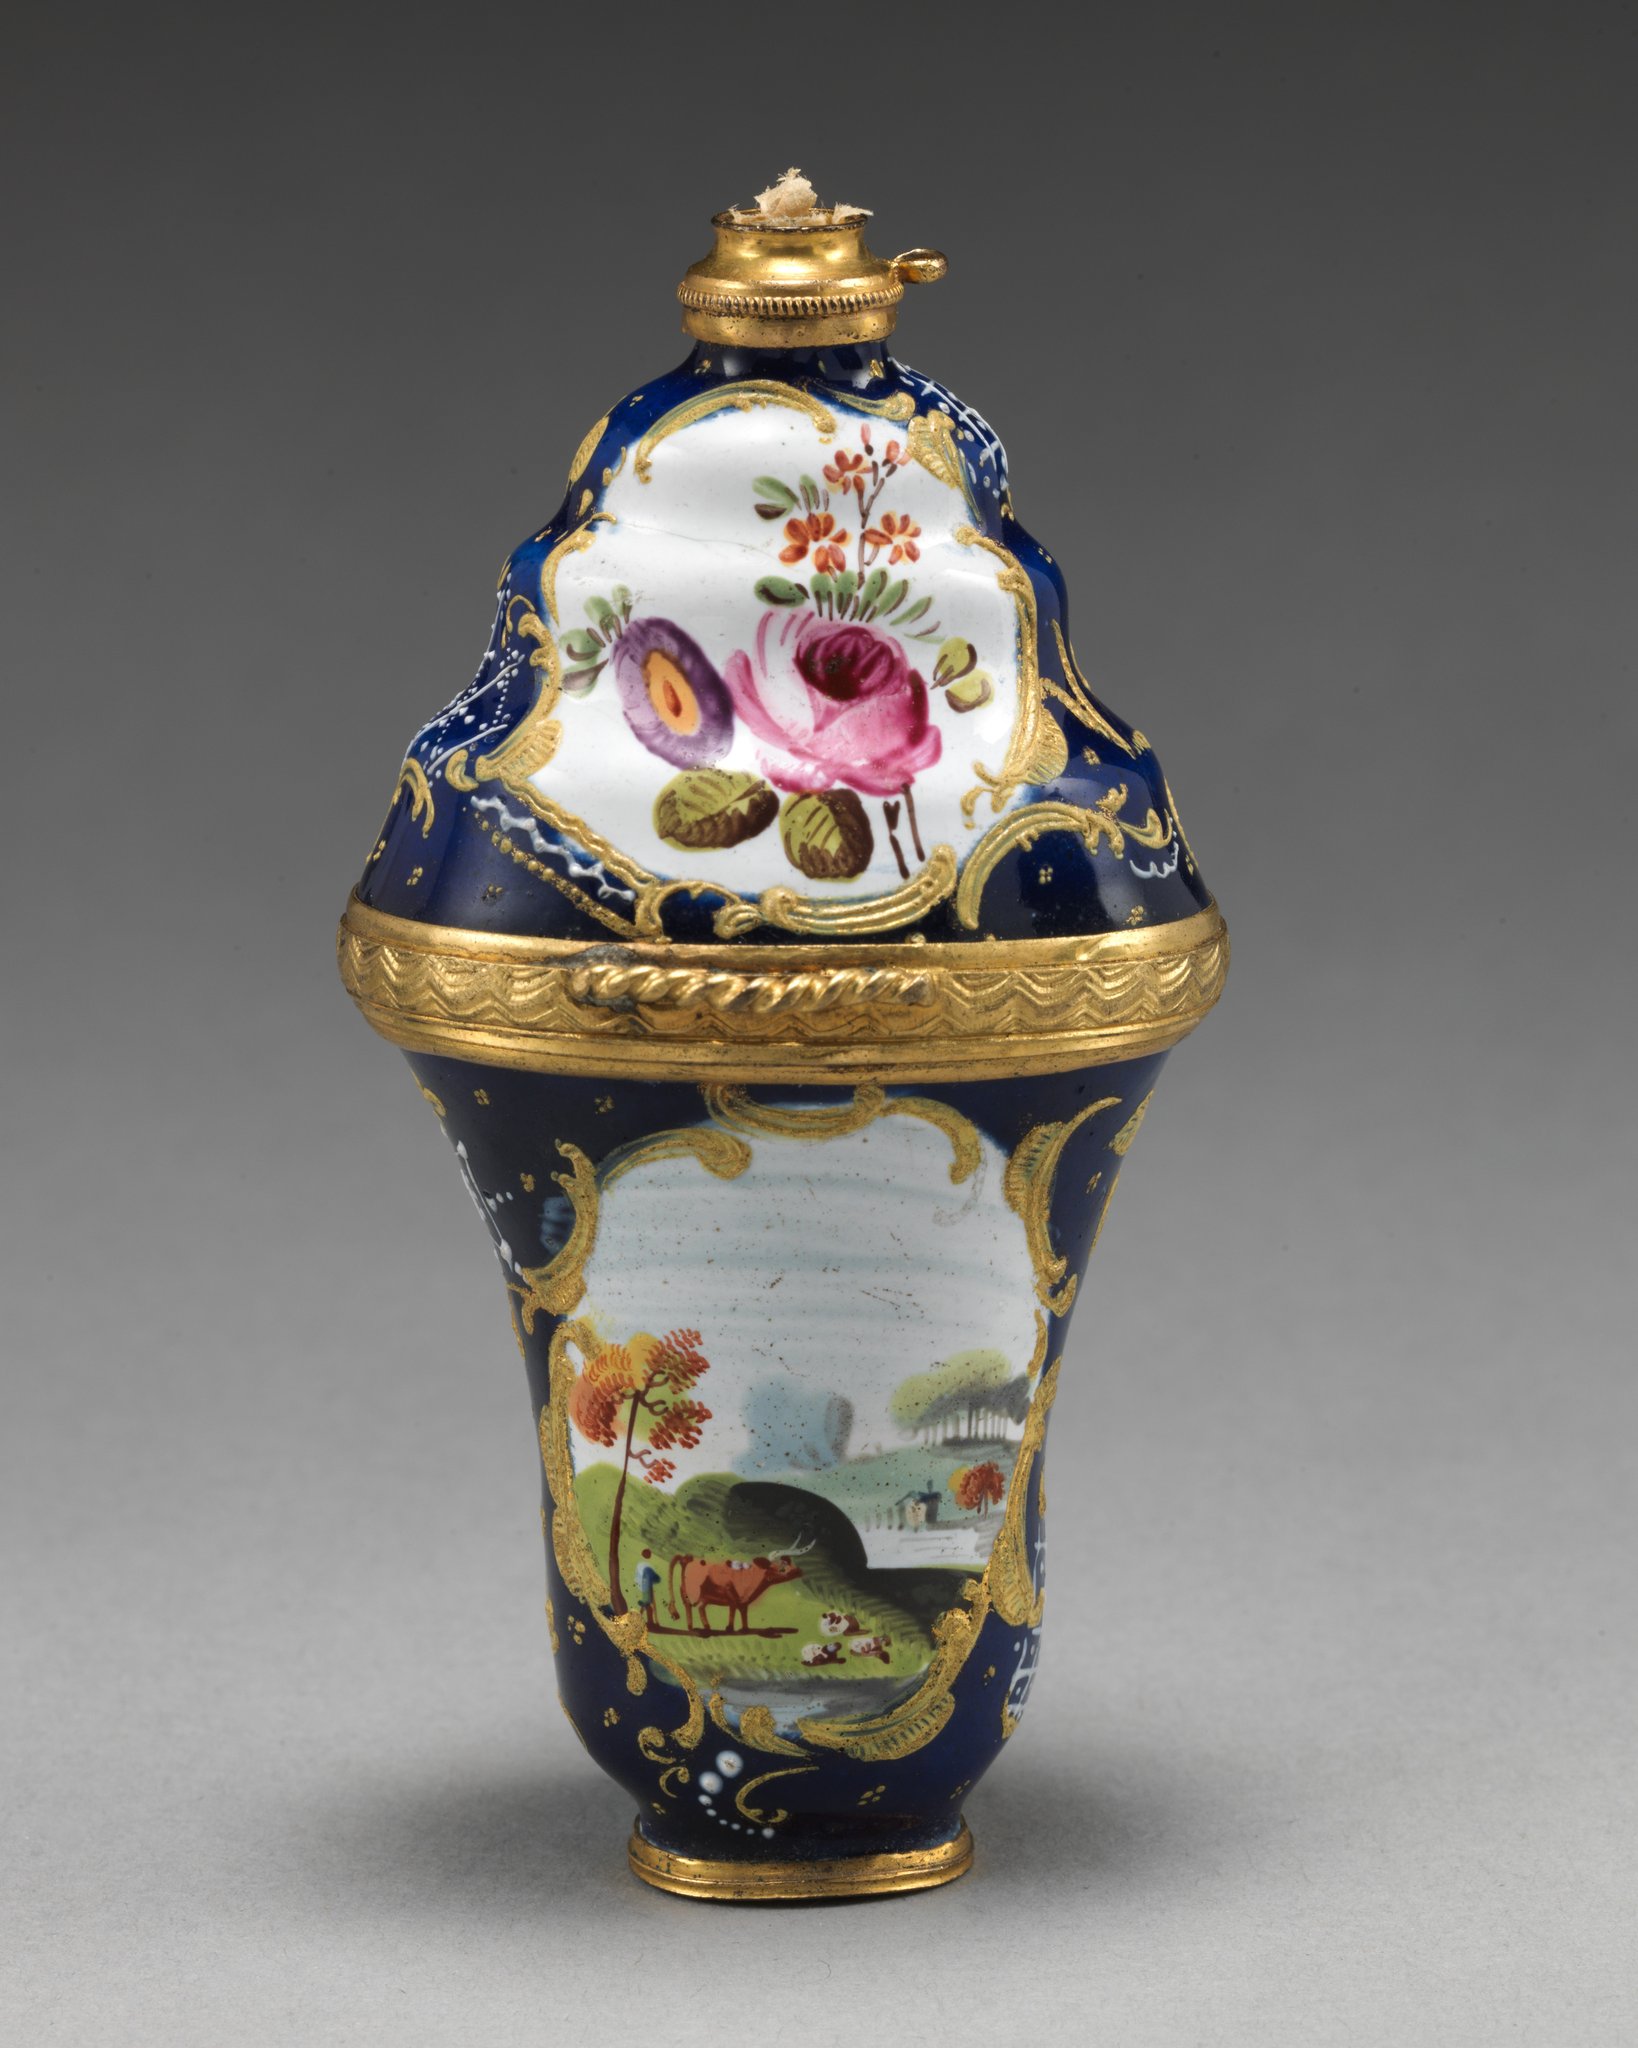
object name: scent bottle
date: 1765-1770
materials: copper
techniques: enamel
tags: flowers,landscapes